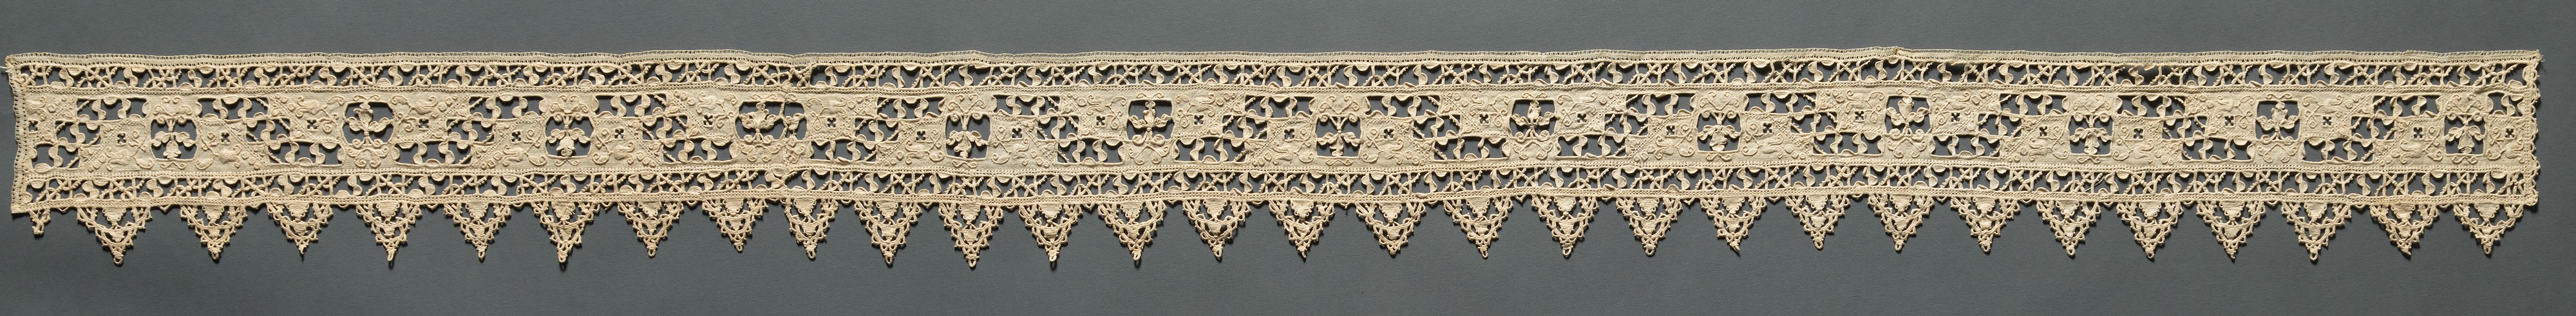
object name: band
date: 1501-1600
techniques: embroidery, lace